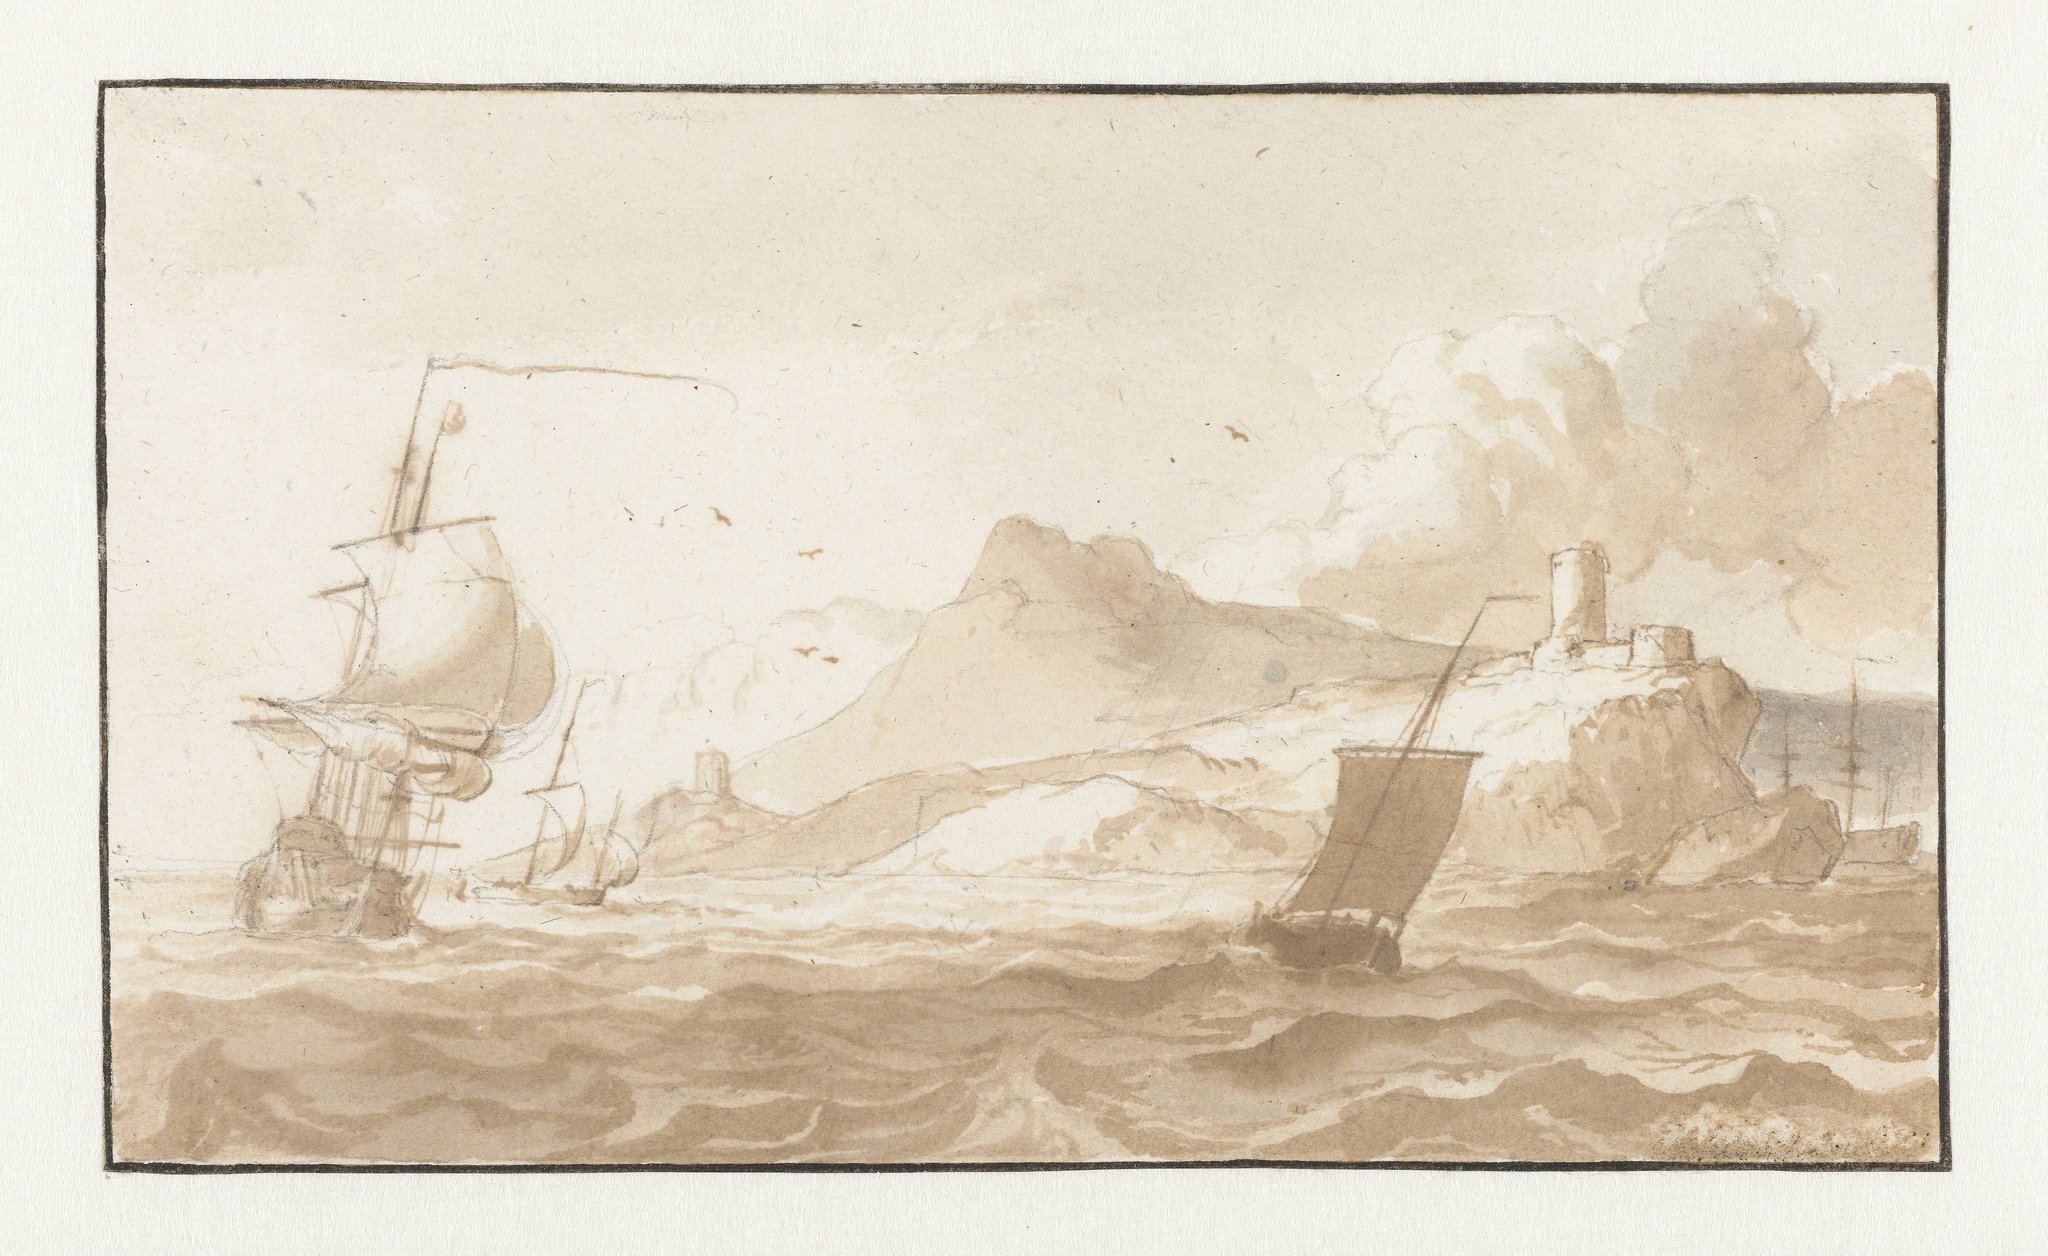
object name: drawing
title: Schepen voor een rotsachtige kust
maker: ludolf bakhuysen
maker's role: draughtsman, print maker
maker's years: 1631-1708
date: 1641-1708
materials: chalk, graphite, ink, paper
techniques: brush, pen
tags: sailing-ship, sailing-boat, rocky coast